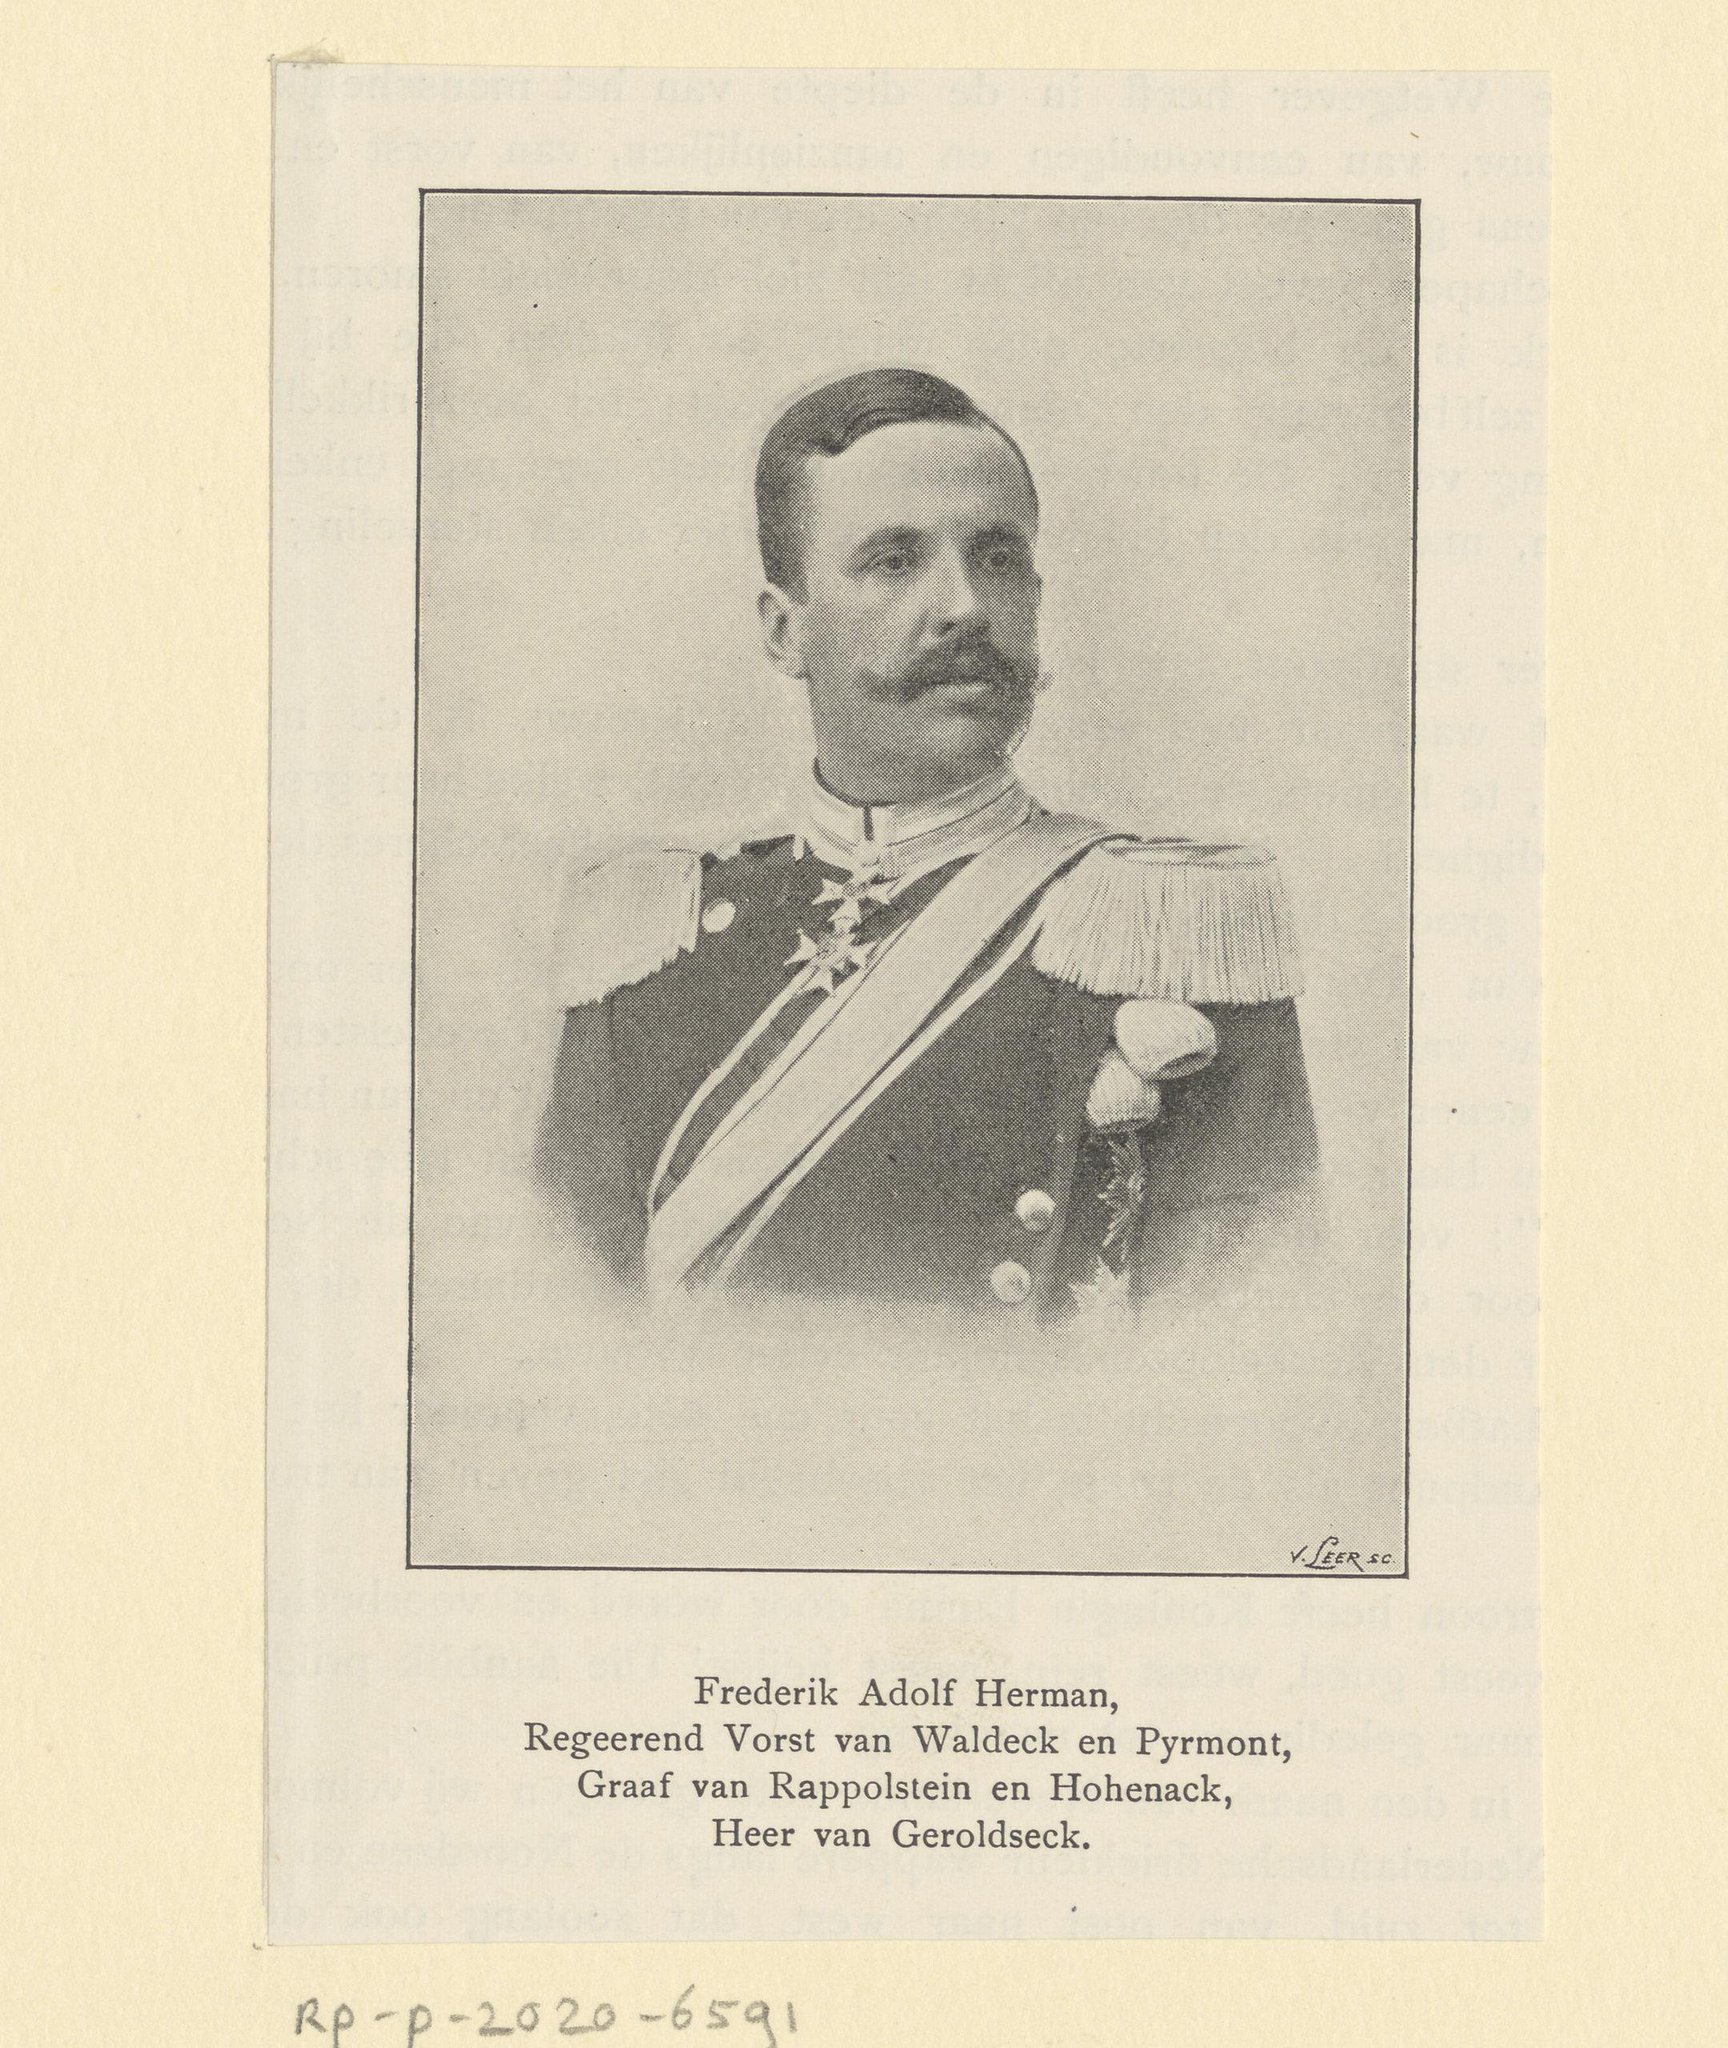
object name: photomechanical print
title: Portret van Frederik van Waldeck-Pyrmont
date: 1898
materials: paper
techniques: letterpress printing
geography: netherlands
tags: historical persons, (military) uniforms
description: Prent uit: Elsevier's Geïllustreerd Maandschrift, 1898.